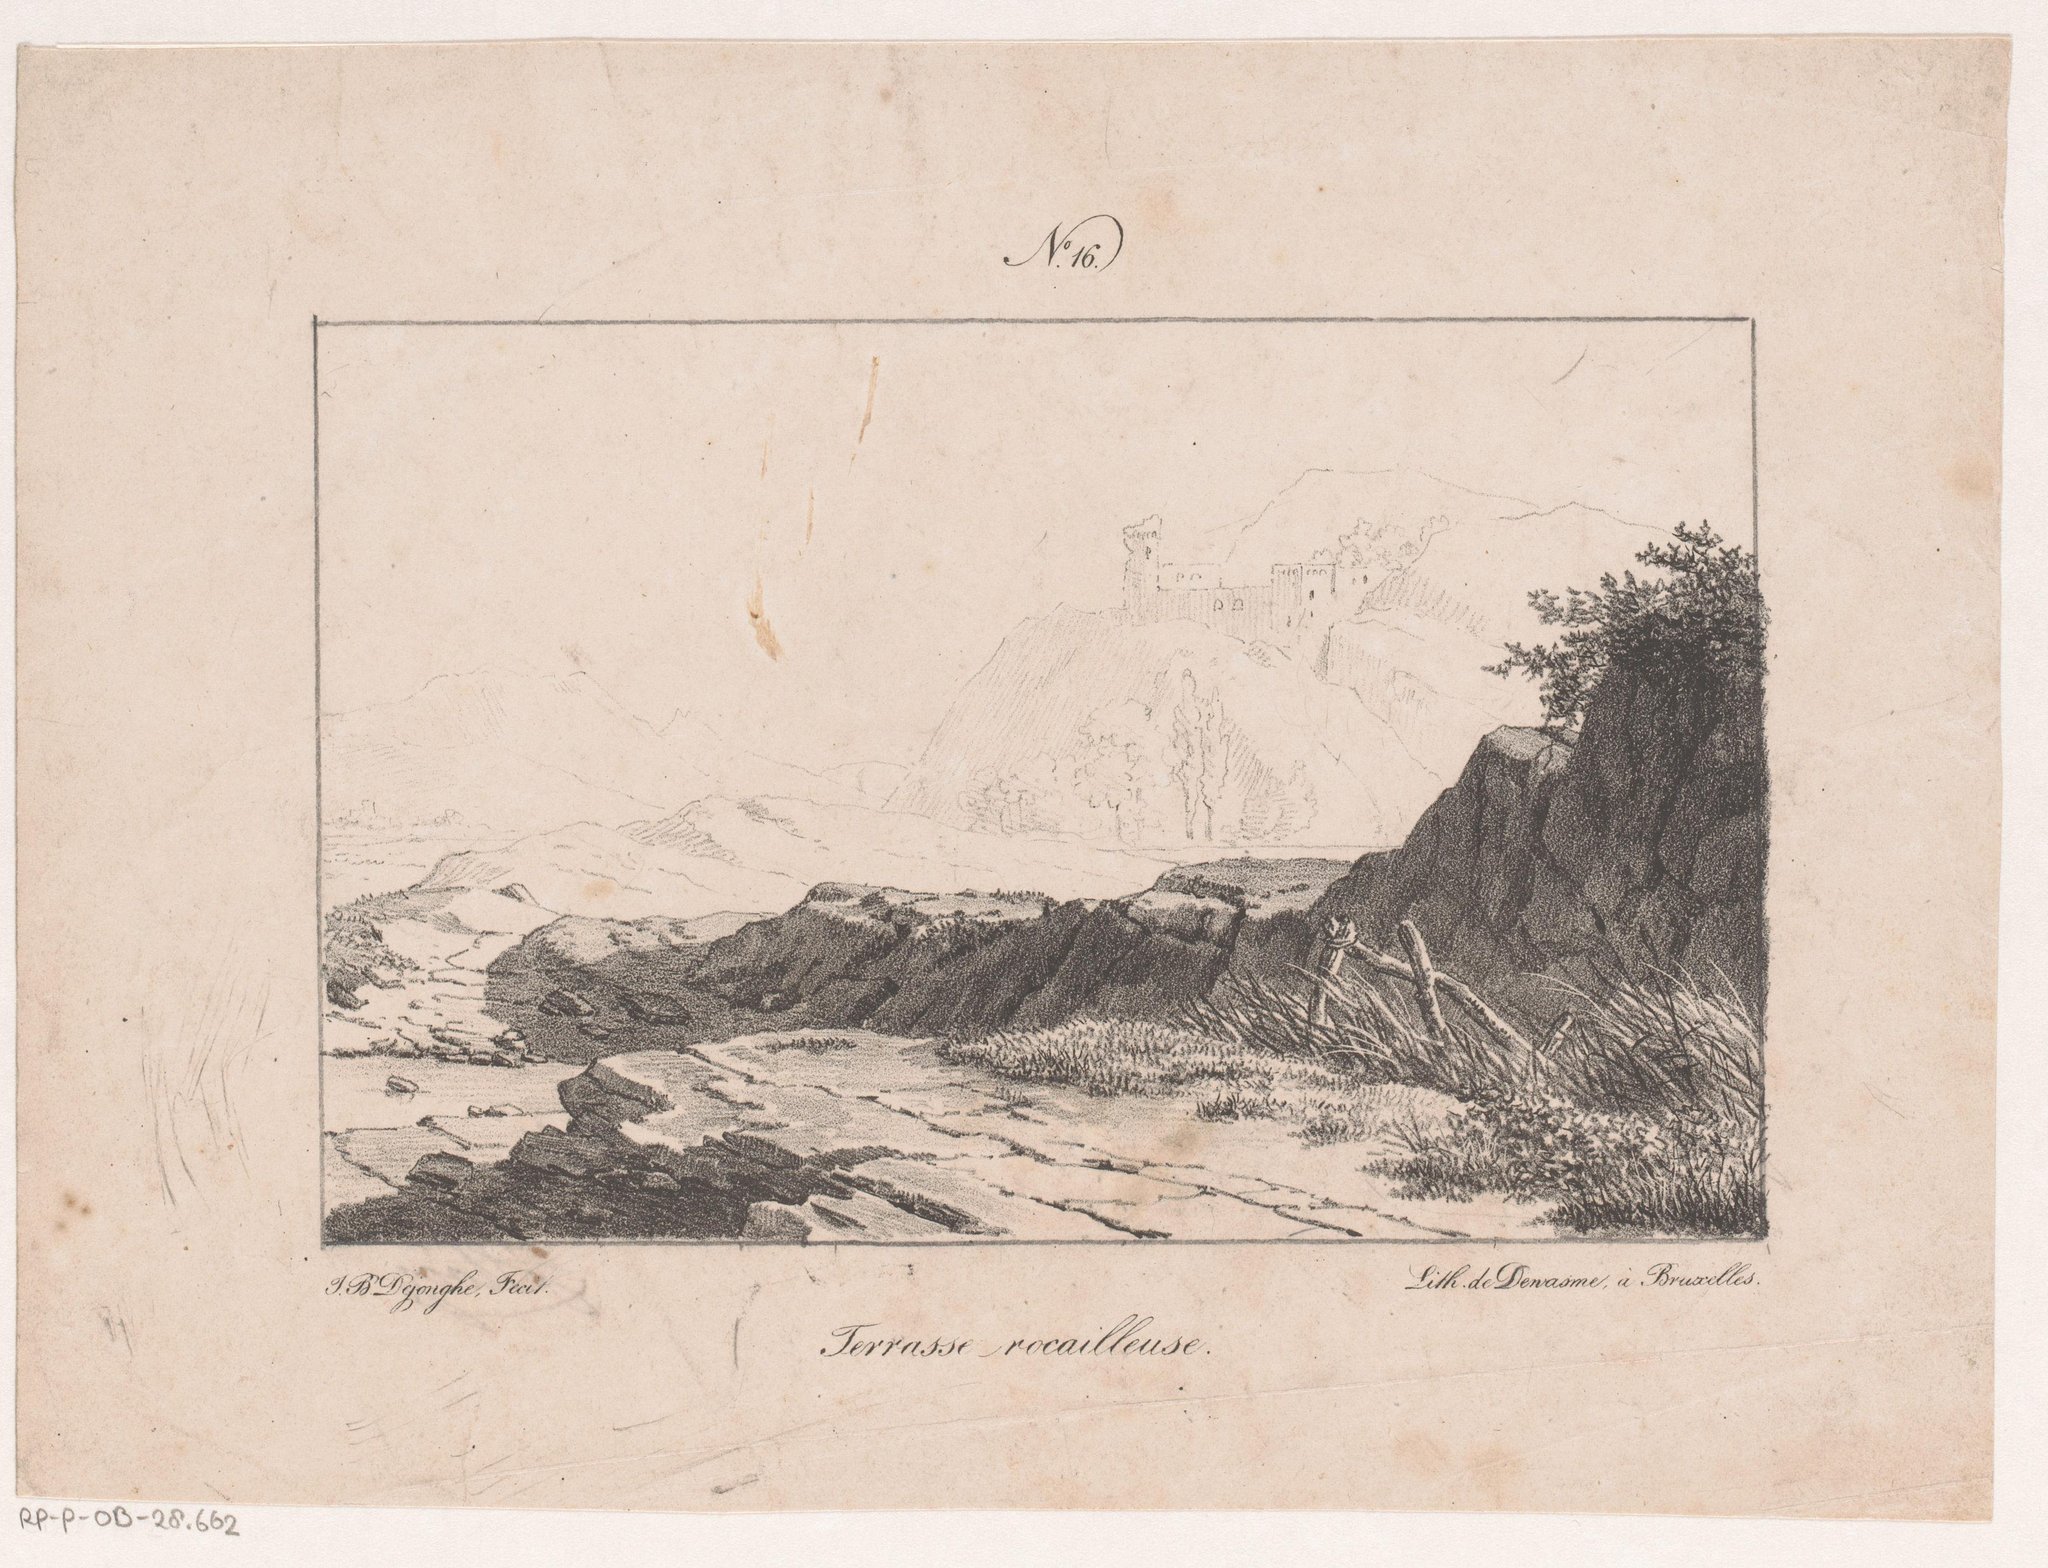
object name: print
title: Rotsplateau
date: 1826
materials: paper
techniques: lithograph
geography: brussels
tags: castle, mountain-top, peak, mountains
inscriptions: signature: ‘J. Sloo(...)’, collector's mark: Lugt 2228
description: Deze prent is zeer waarschijnlijk afkomstig uit: J.B. De Jonghe, 'Principes de paysages dessinés d'après nature et exécutés sur pierre', Brussel 1826. Deze bundels met tekenvoorbeelden gebruikte De Jonghe tijdens zijn docentschap in Kortwijk. Zie: L. Pil 1993.